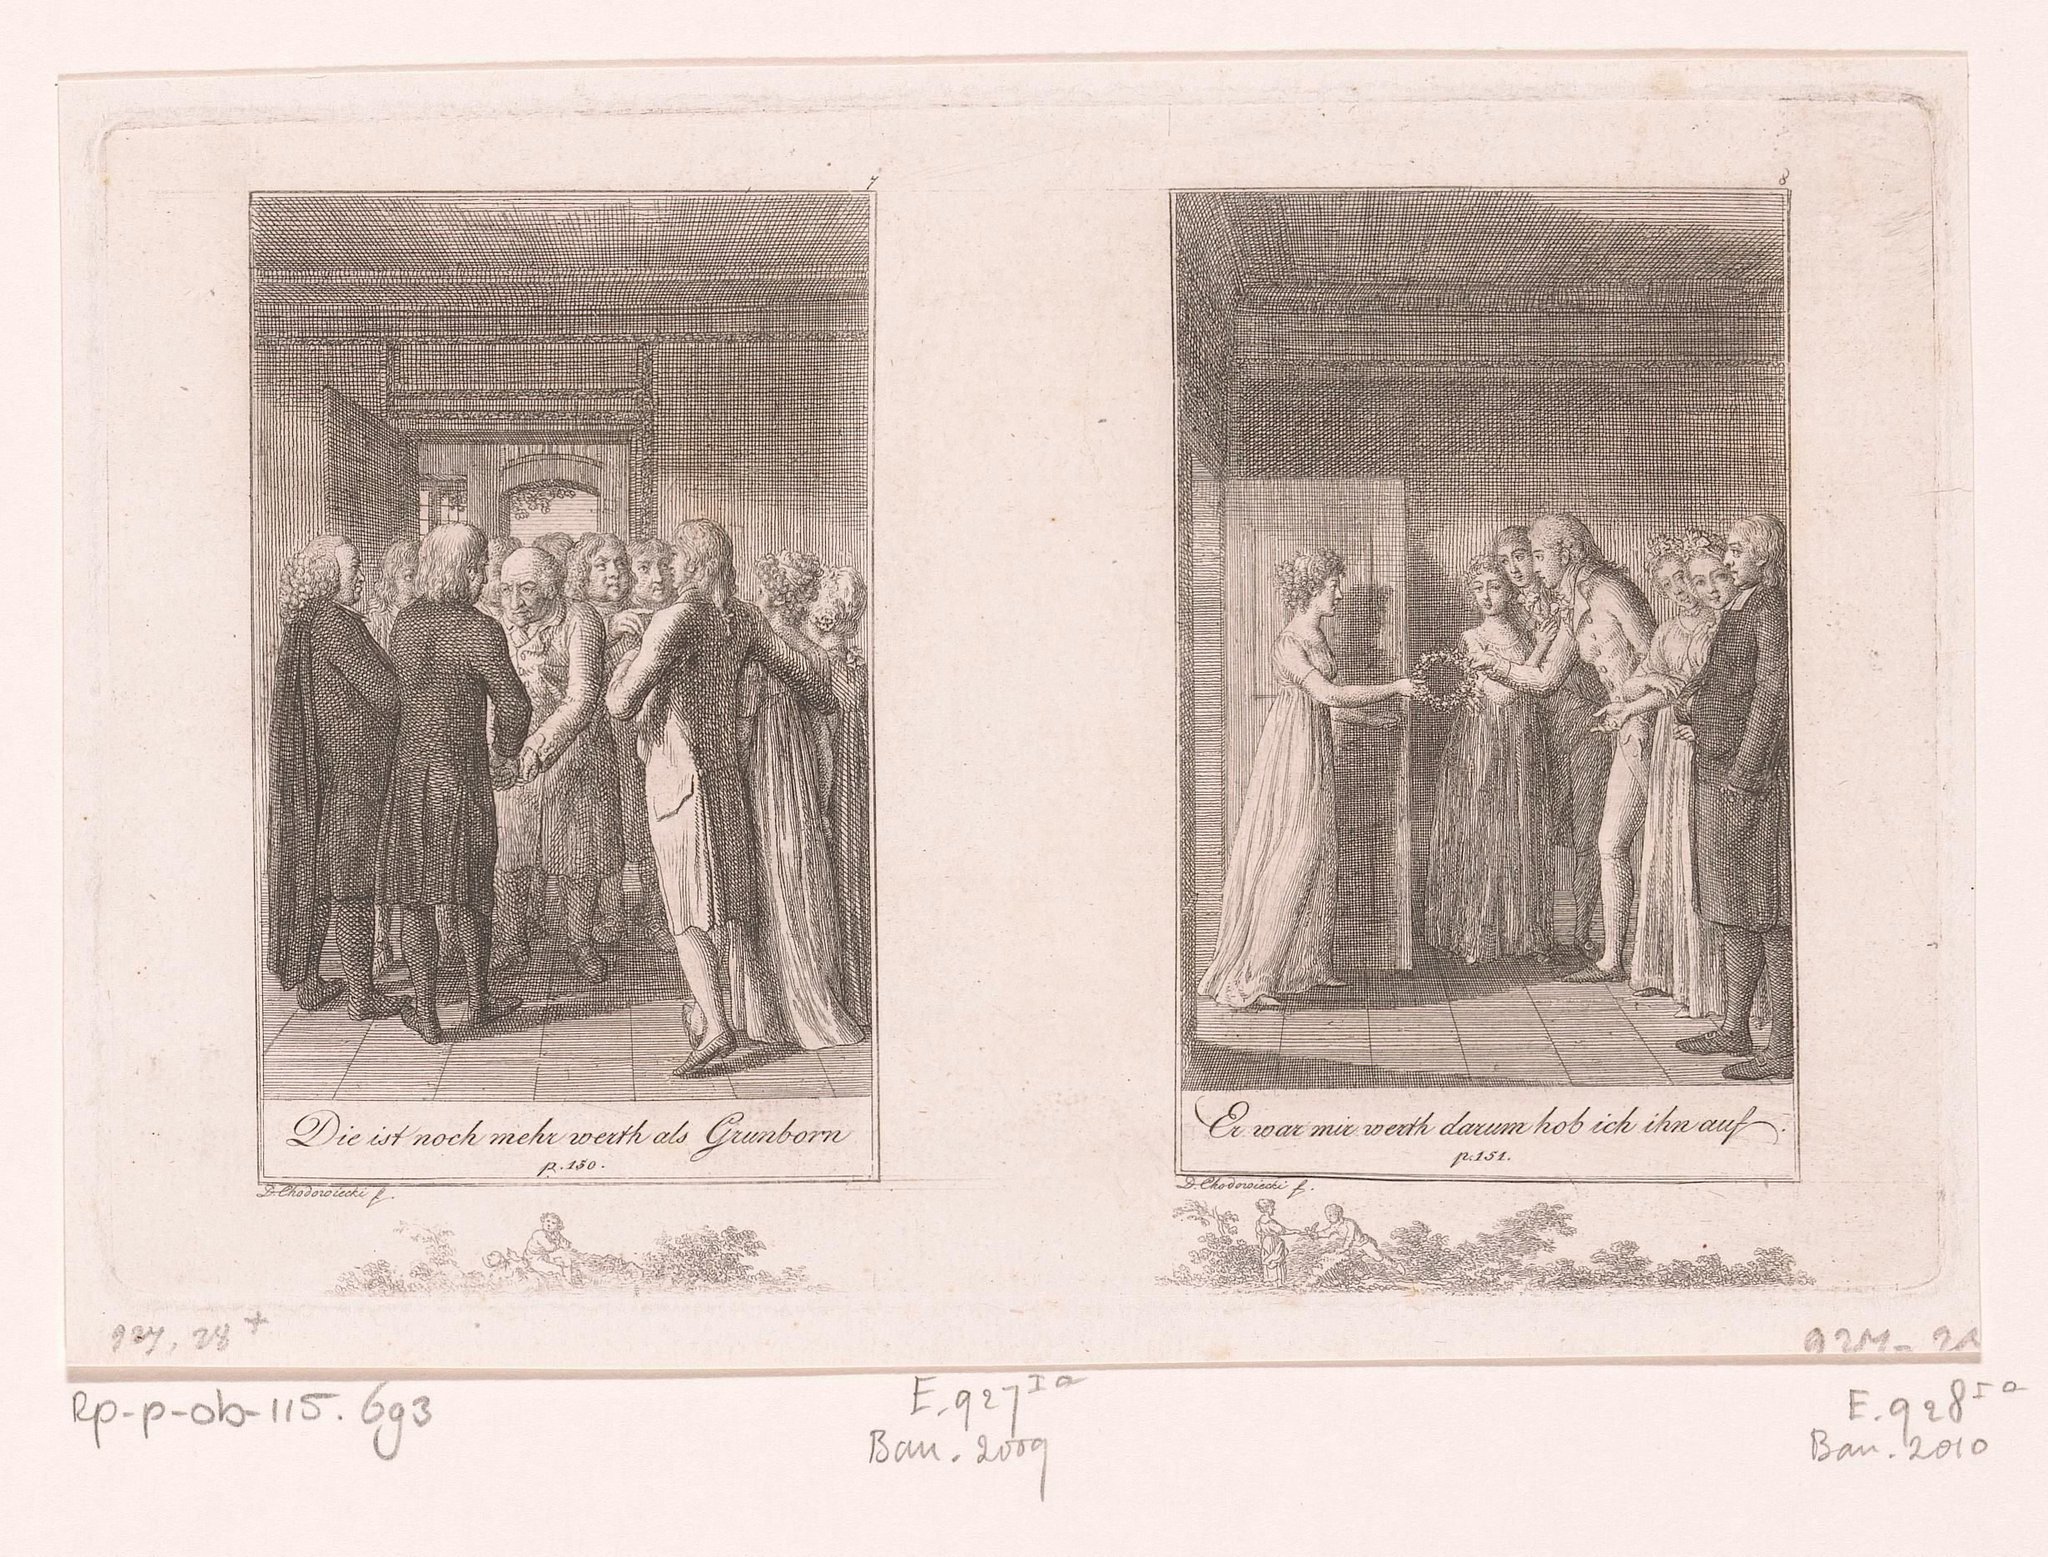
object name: print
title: Twee voorstellingen uit de verhalen van Wilhelm Gottlieb Becker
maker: daniel nikolaus chodowiecki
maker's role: draughtsman, print maker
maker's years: 1726-1801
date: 1800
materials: paper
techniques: etching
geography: berlin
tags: garland, wreath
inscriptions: collector's mark: Lugt 2228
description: De prenten zijn rechtsboven genummerd. Met onderschrift en paginaverwijzing in het Duits. In de marge zijn op schetsmatige wijze verschillende figuren geëtst.